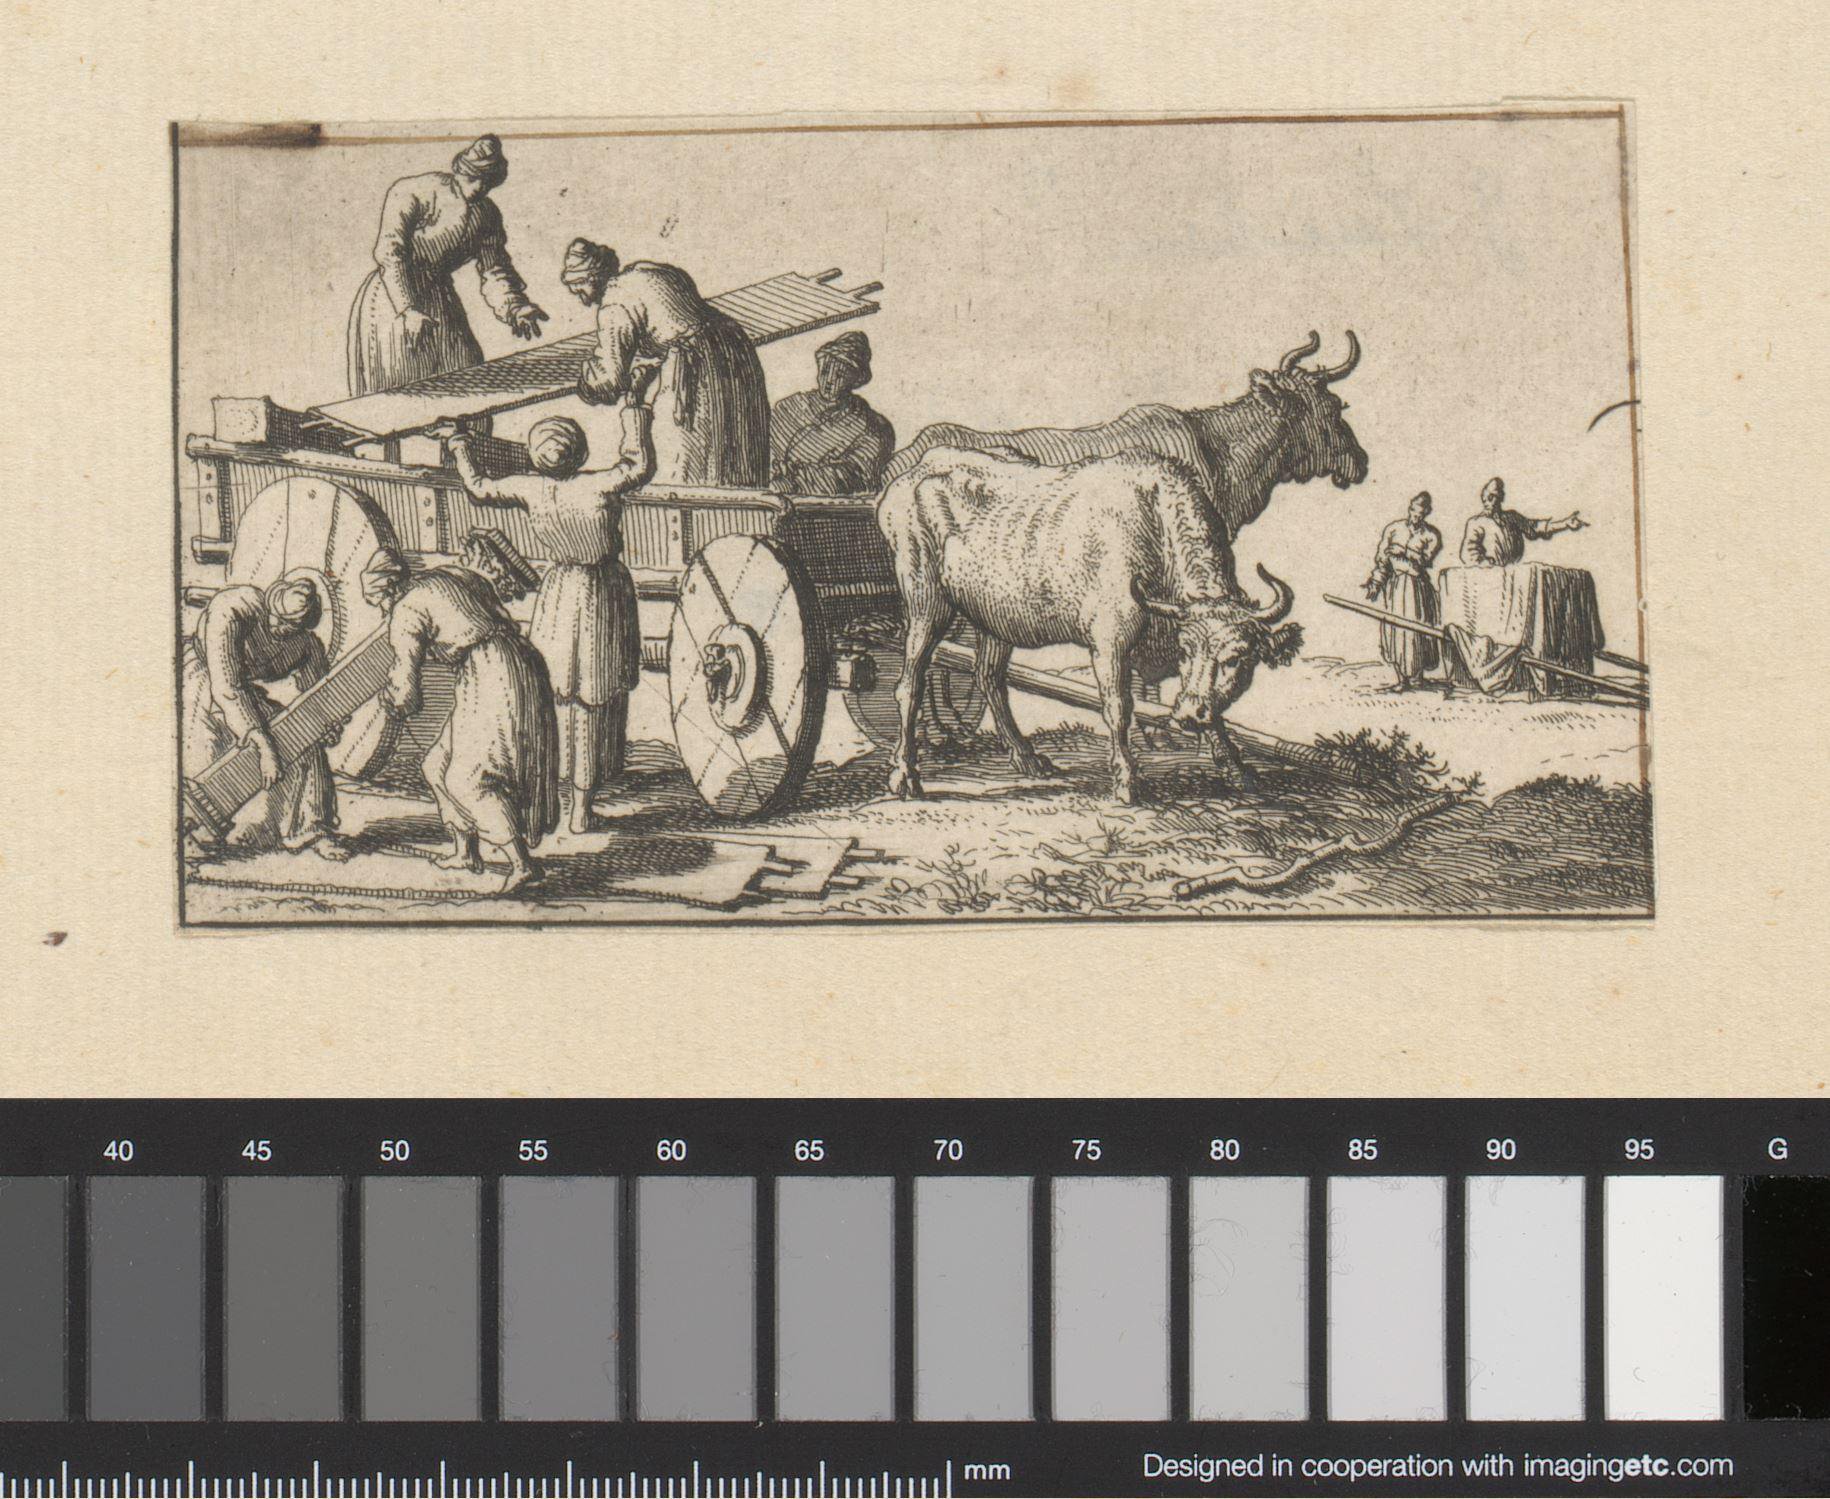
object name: print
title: Houtladen op een boerenwagen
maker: jan luyken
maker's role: draughtsman, print maker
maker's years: 1649-1712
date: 1659-1712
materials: paper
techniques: etching